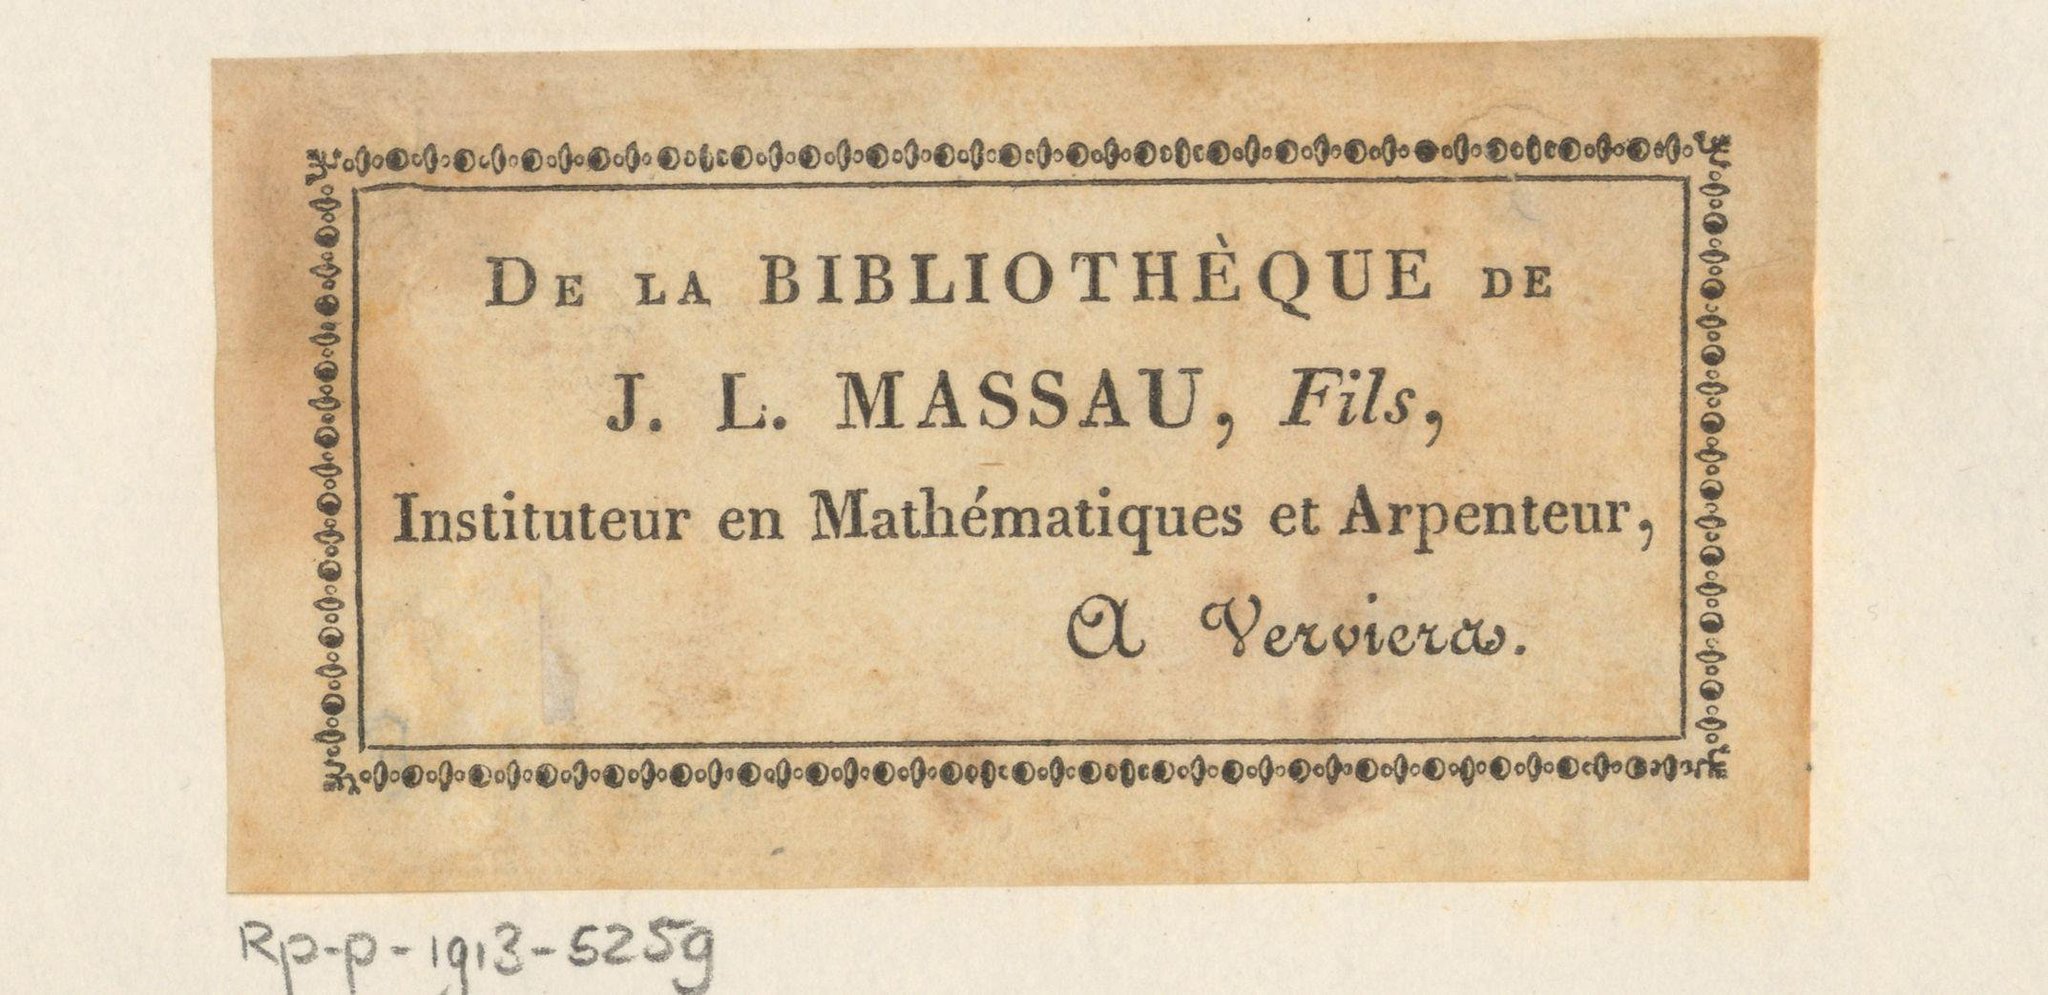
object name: bookplate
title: Ex libris van De la Bibliothèque de J.L. Massau, Fils, Instituteur en Mathématiques et Arpenteur, A Verviera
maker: Anonymous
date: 1850-1899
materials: paper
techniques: letterpress printing, relief print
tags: armorial bearing, heraldry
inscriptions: collector's mark: Lugt 2760, collector's mark: Lugt 2233